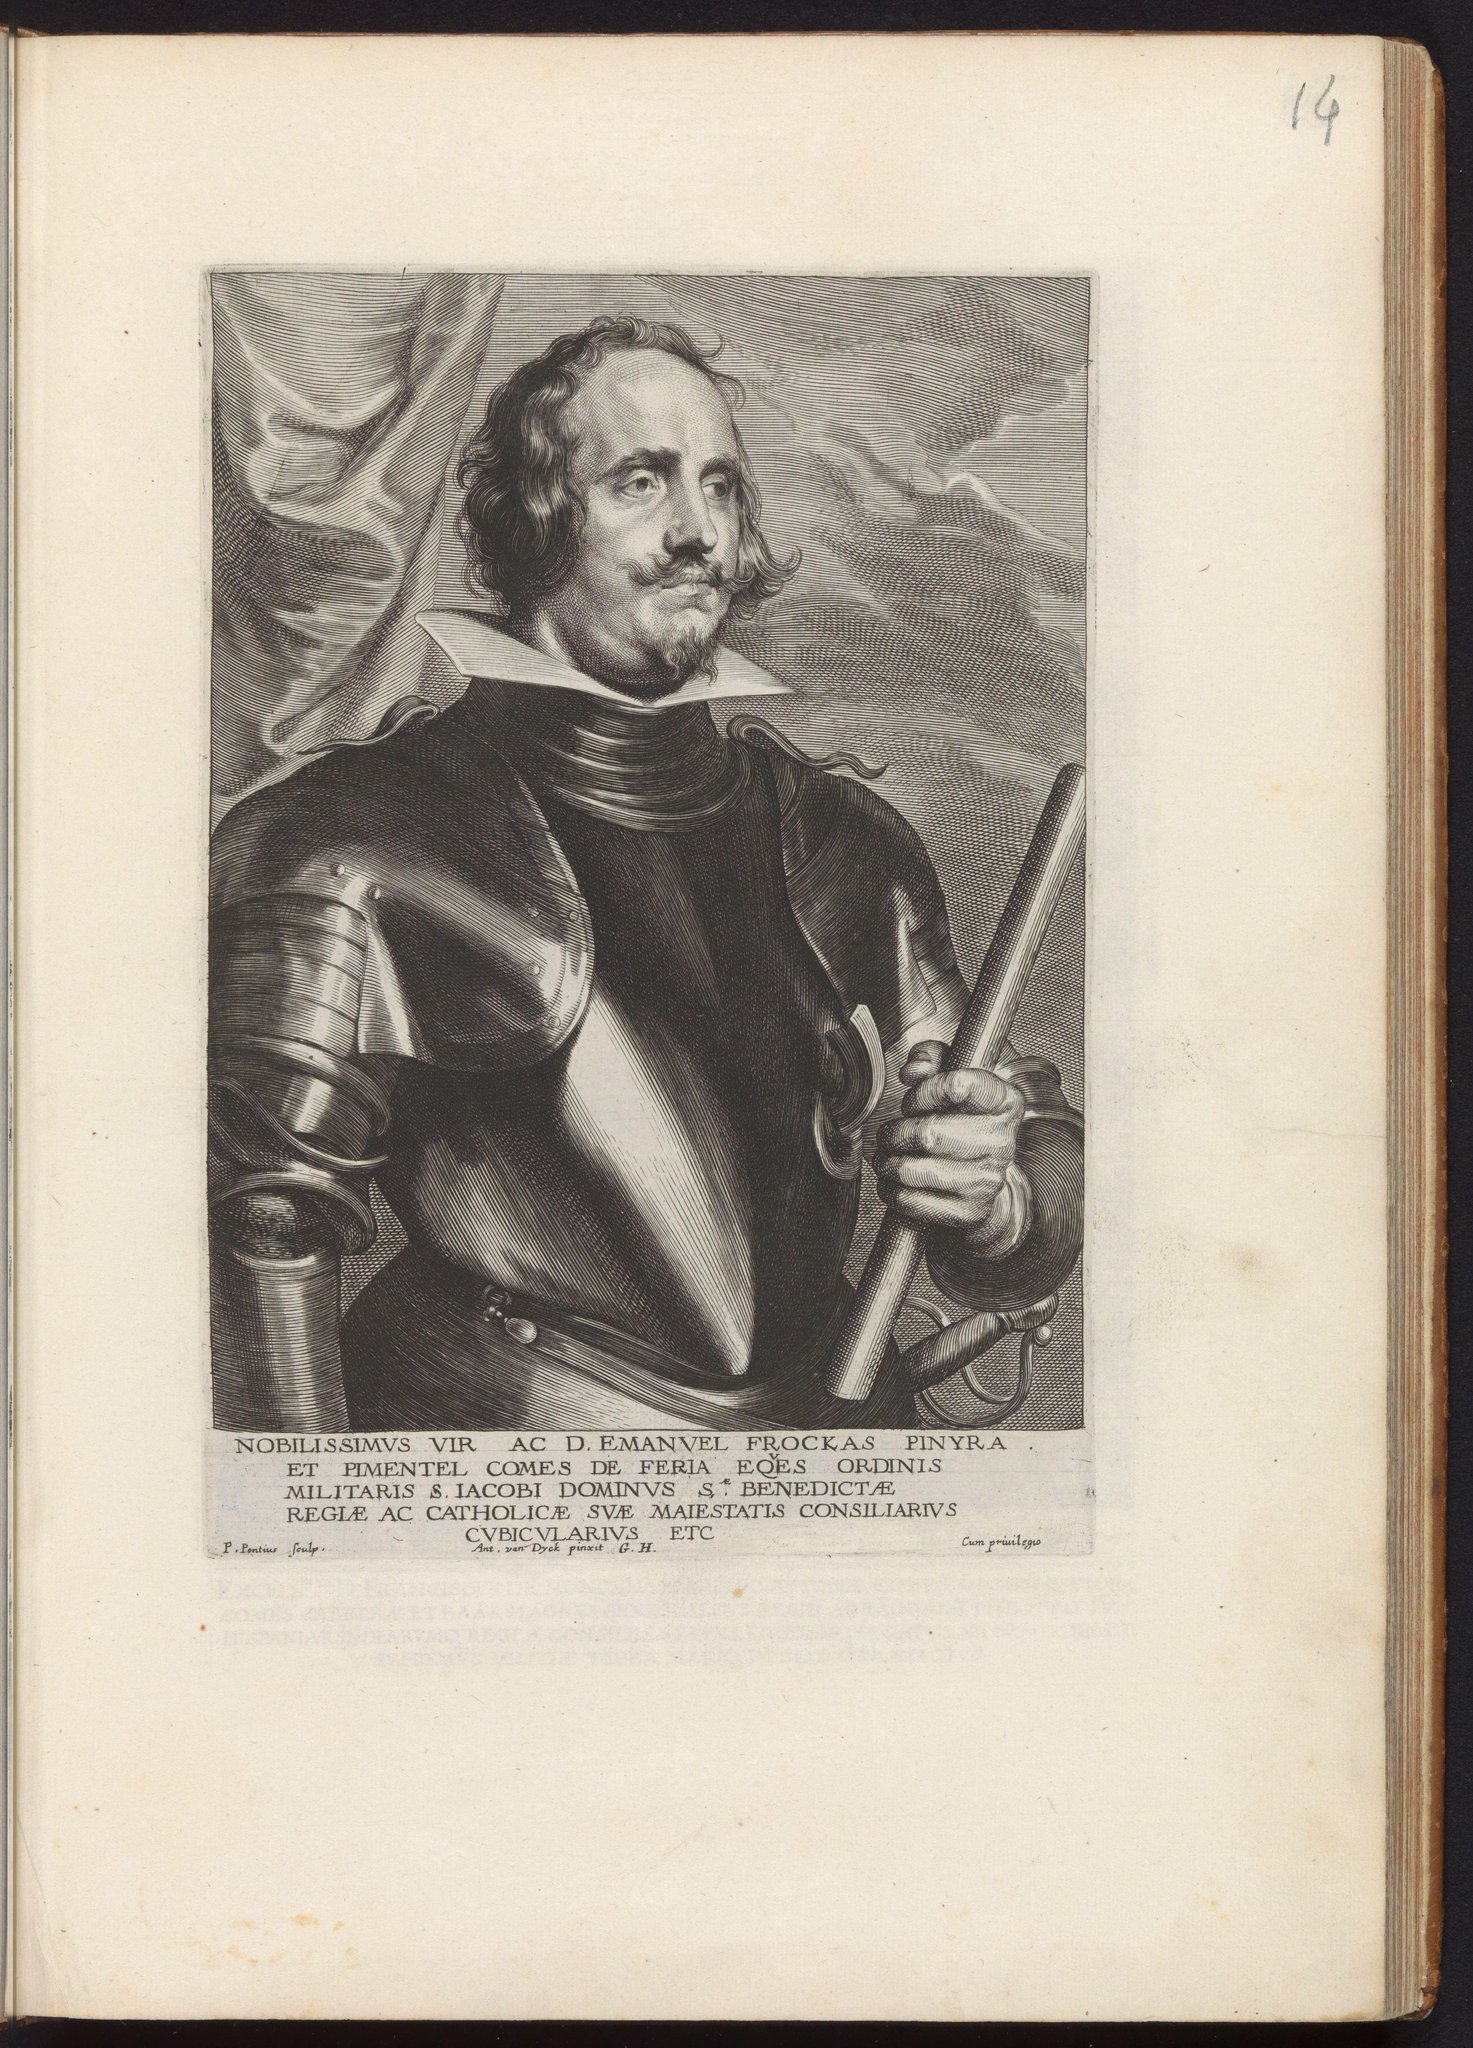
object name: album leaf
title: Icones Principum Vivorum Doctorum Pictorum Chalcographorum Statuariorum nec non Amatorum Pictoriae Artis Numero Centum ab Antonio van Dyck Pictore ad Vivum Expressae Eiusq: Sumptibus aeri incisae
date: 1630-1641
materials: paper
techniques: engraving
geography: antwerp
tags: armour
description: Deze prent maakt deel uit van een album.